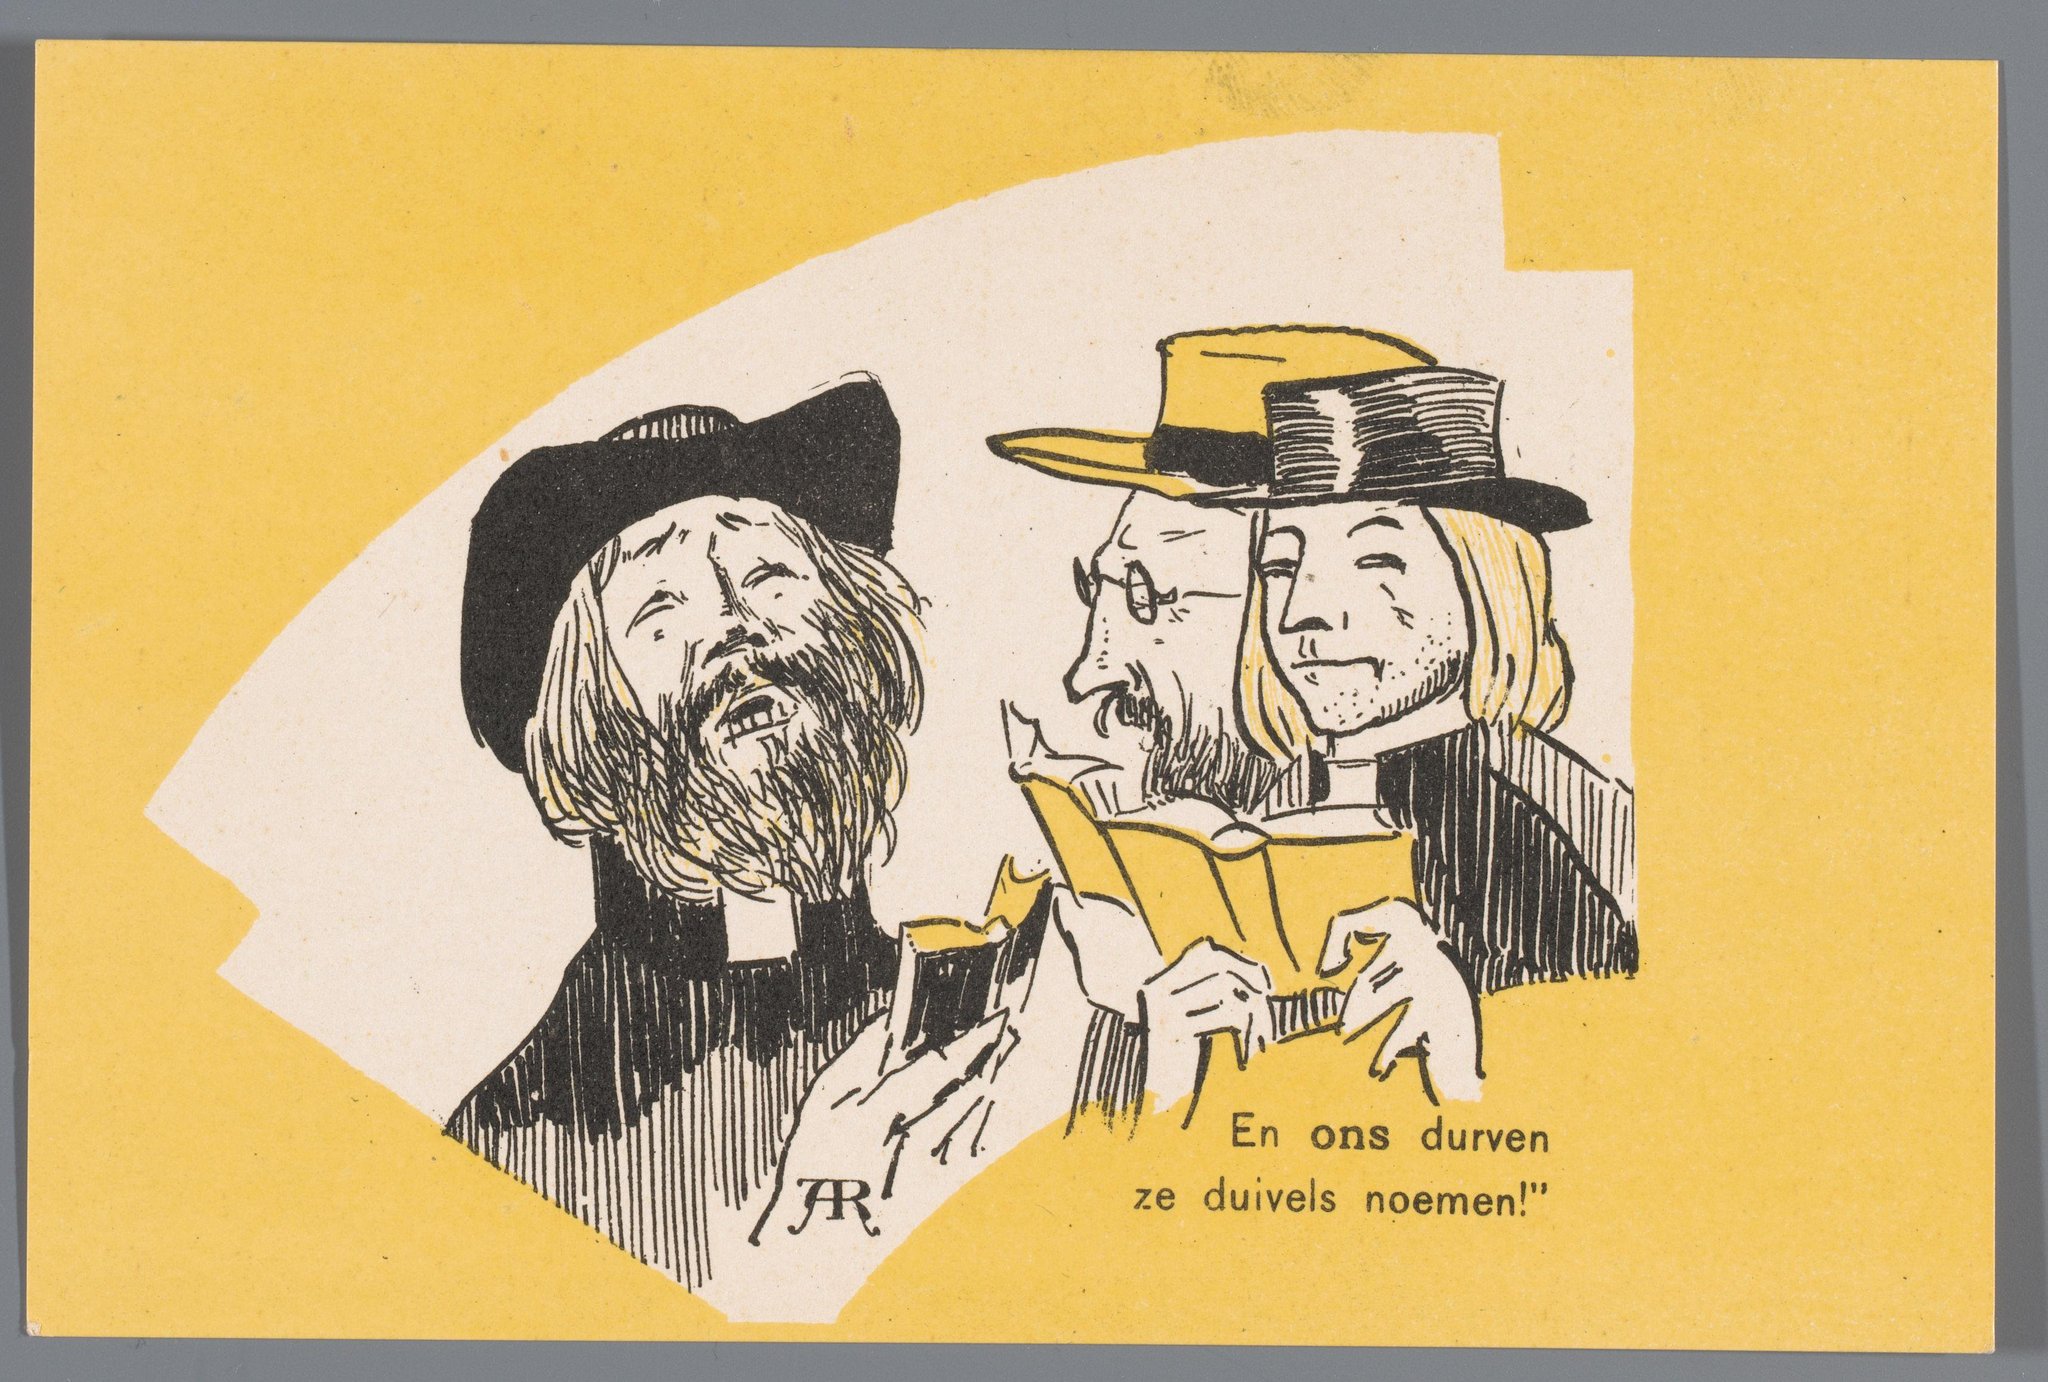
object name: cartoon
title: China prentbriefkaart 'En ons durven ze duivels noemen!'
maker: alfaro reijding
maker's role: draughtsman, engineer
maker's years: 1863-1930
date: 1900-1918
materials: paper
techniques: printing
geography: netherlands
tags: political caricatures and satires, china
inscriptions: : ‘En ons durven / ze duivels noemen!"’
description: Prentbriefkaart in zwart en geel met drie mannen, elk met hoed en boek.